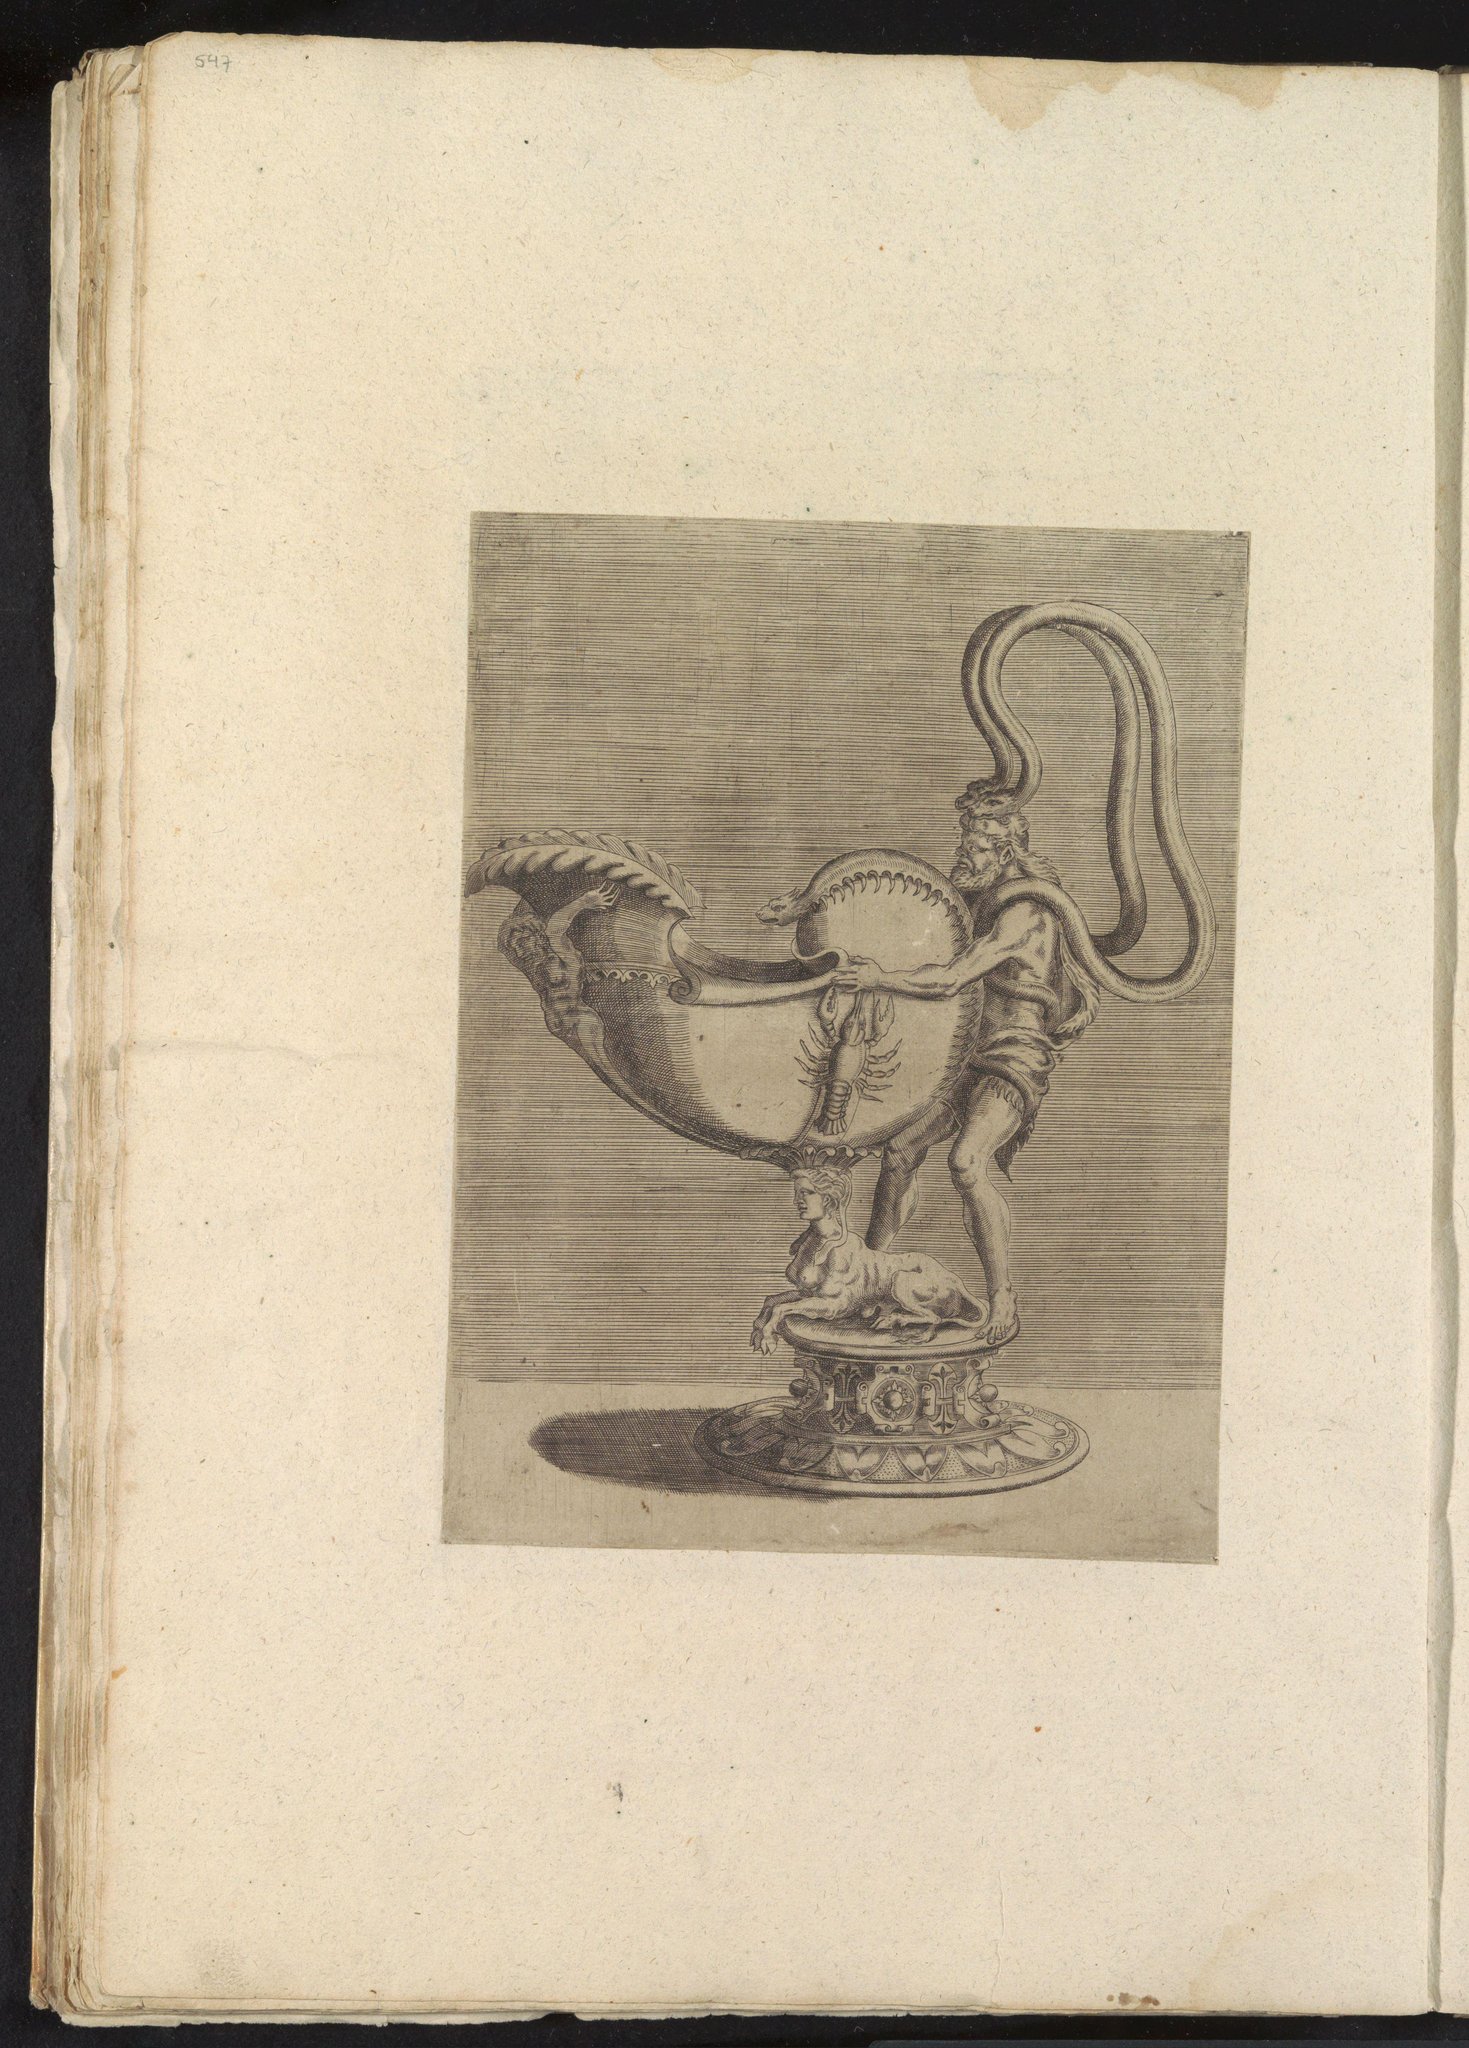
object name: ornament print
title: Albumblad met een prent van een nautilusbokaal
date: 1500-1599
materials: paper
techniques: engraving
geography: low countries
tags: kitchen-utensils: cauldron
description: Albumblad met een uitgeknipte prent van een ornamentele nautilusbokaal.